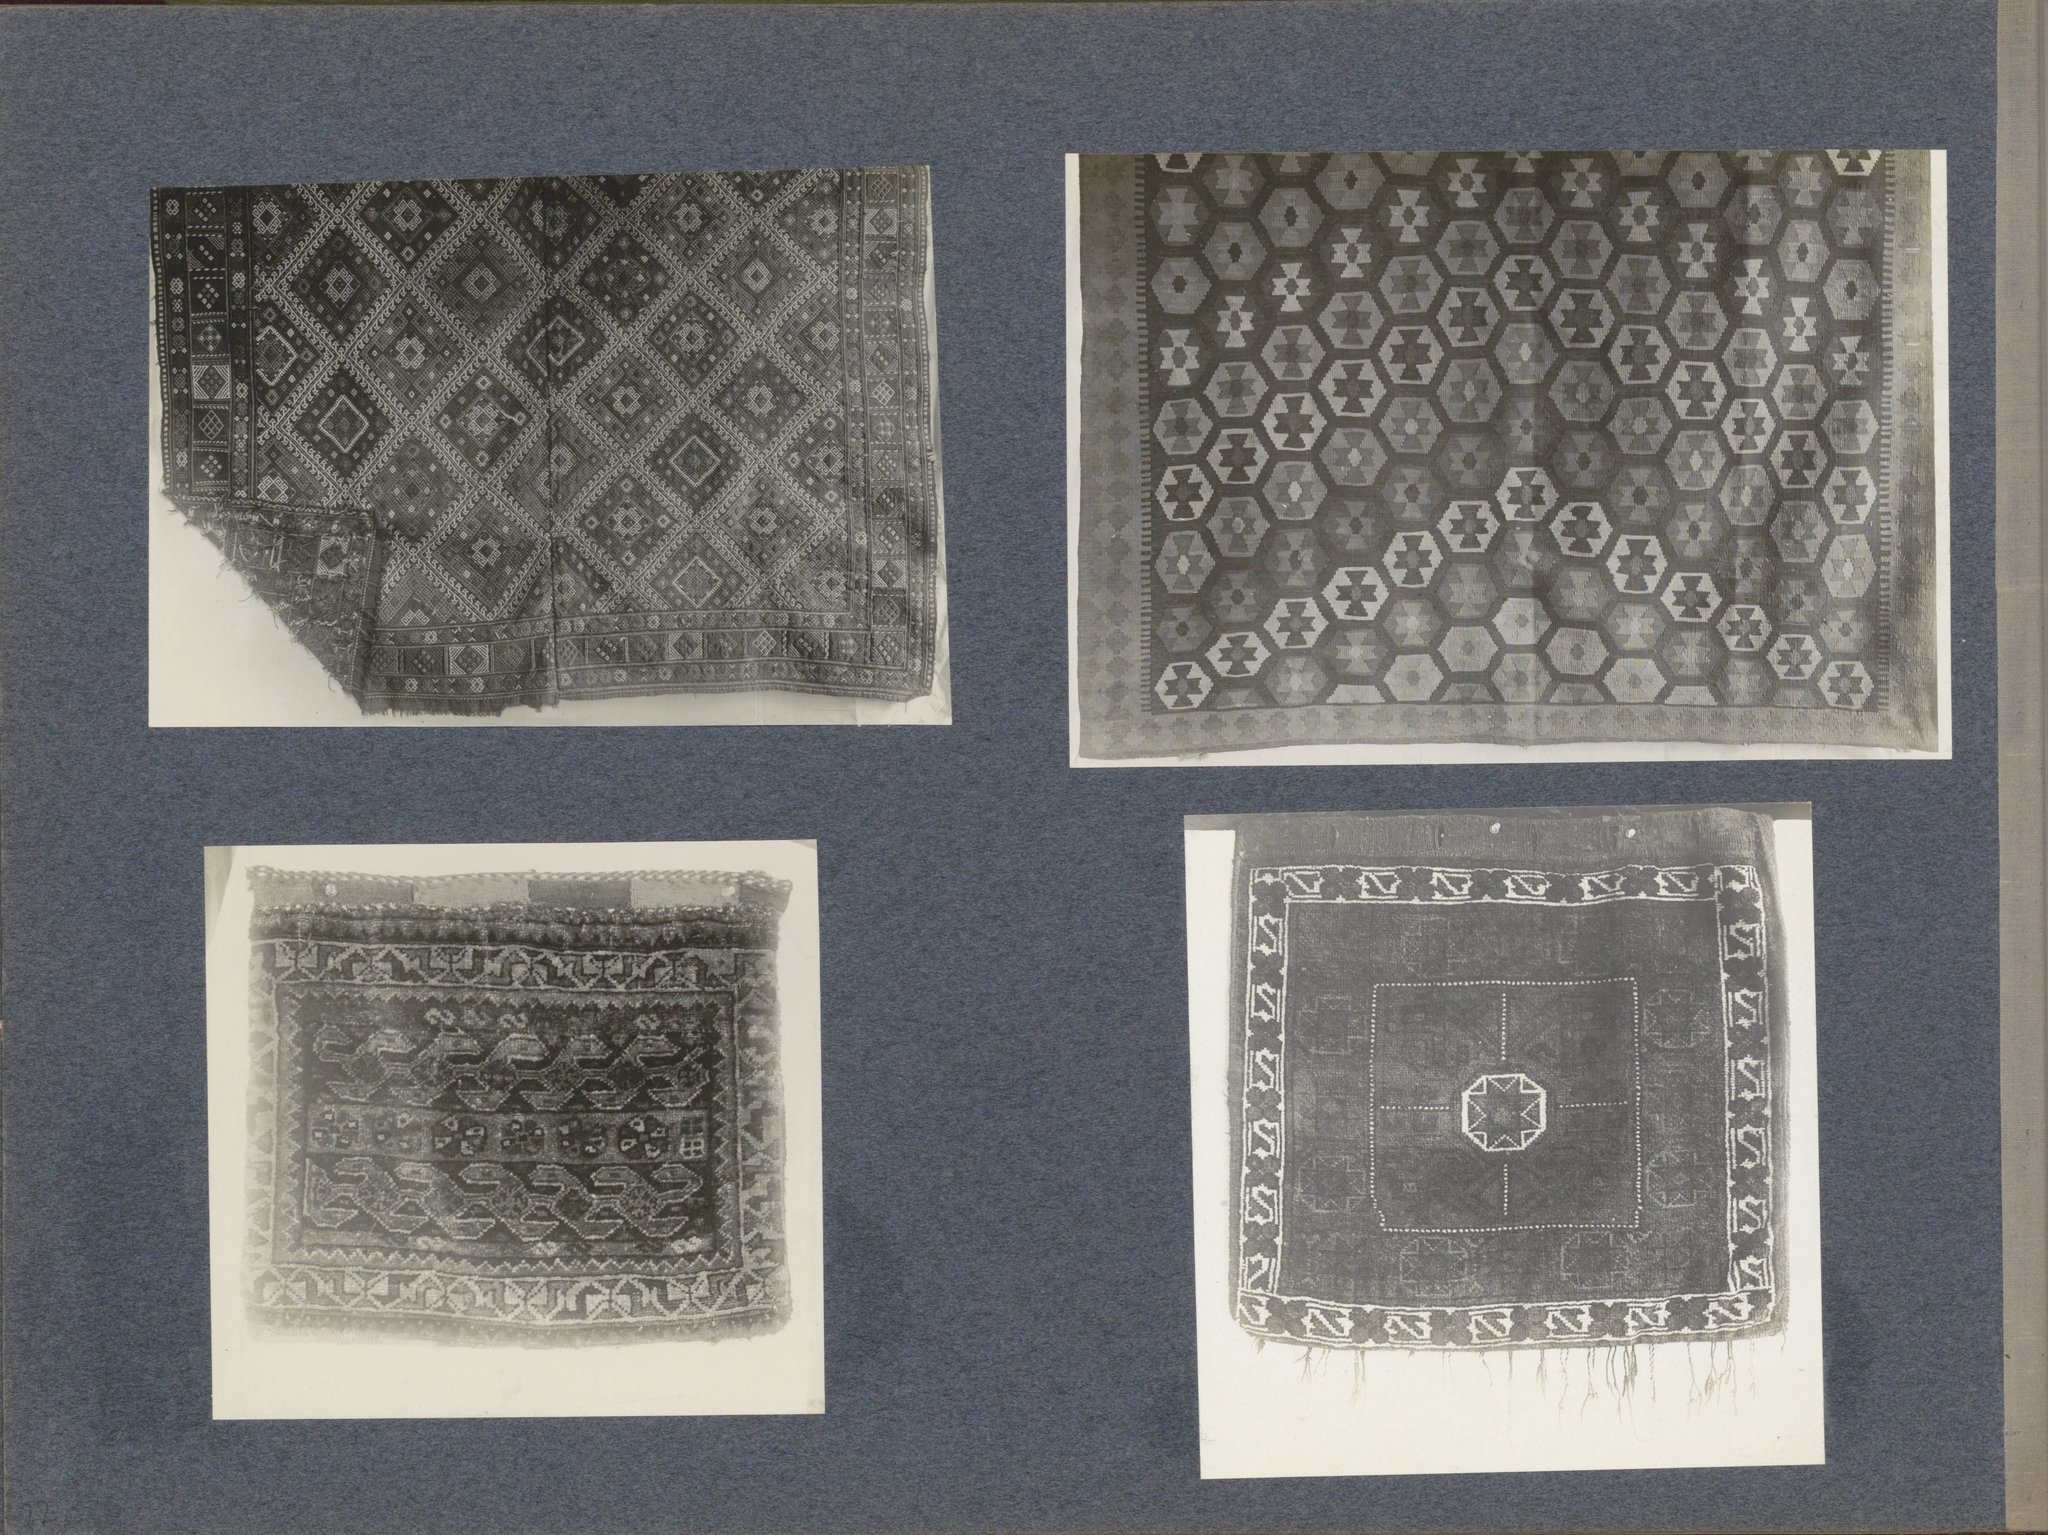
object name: album leaf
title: Tapijten (1)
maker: Anonymous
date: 1910-1911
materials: cardboard, paper, photographic support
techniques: gelatin silver print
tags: carpet, rug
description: Albumblad met vier foto's van tapijten. Onderdeel van Fotoalbum van de familie Palthe uit Almelo.